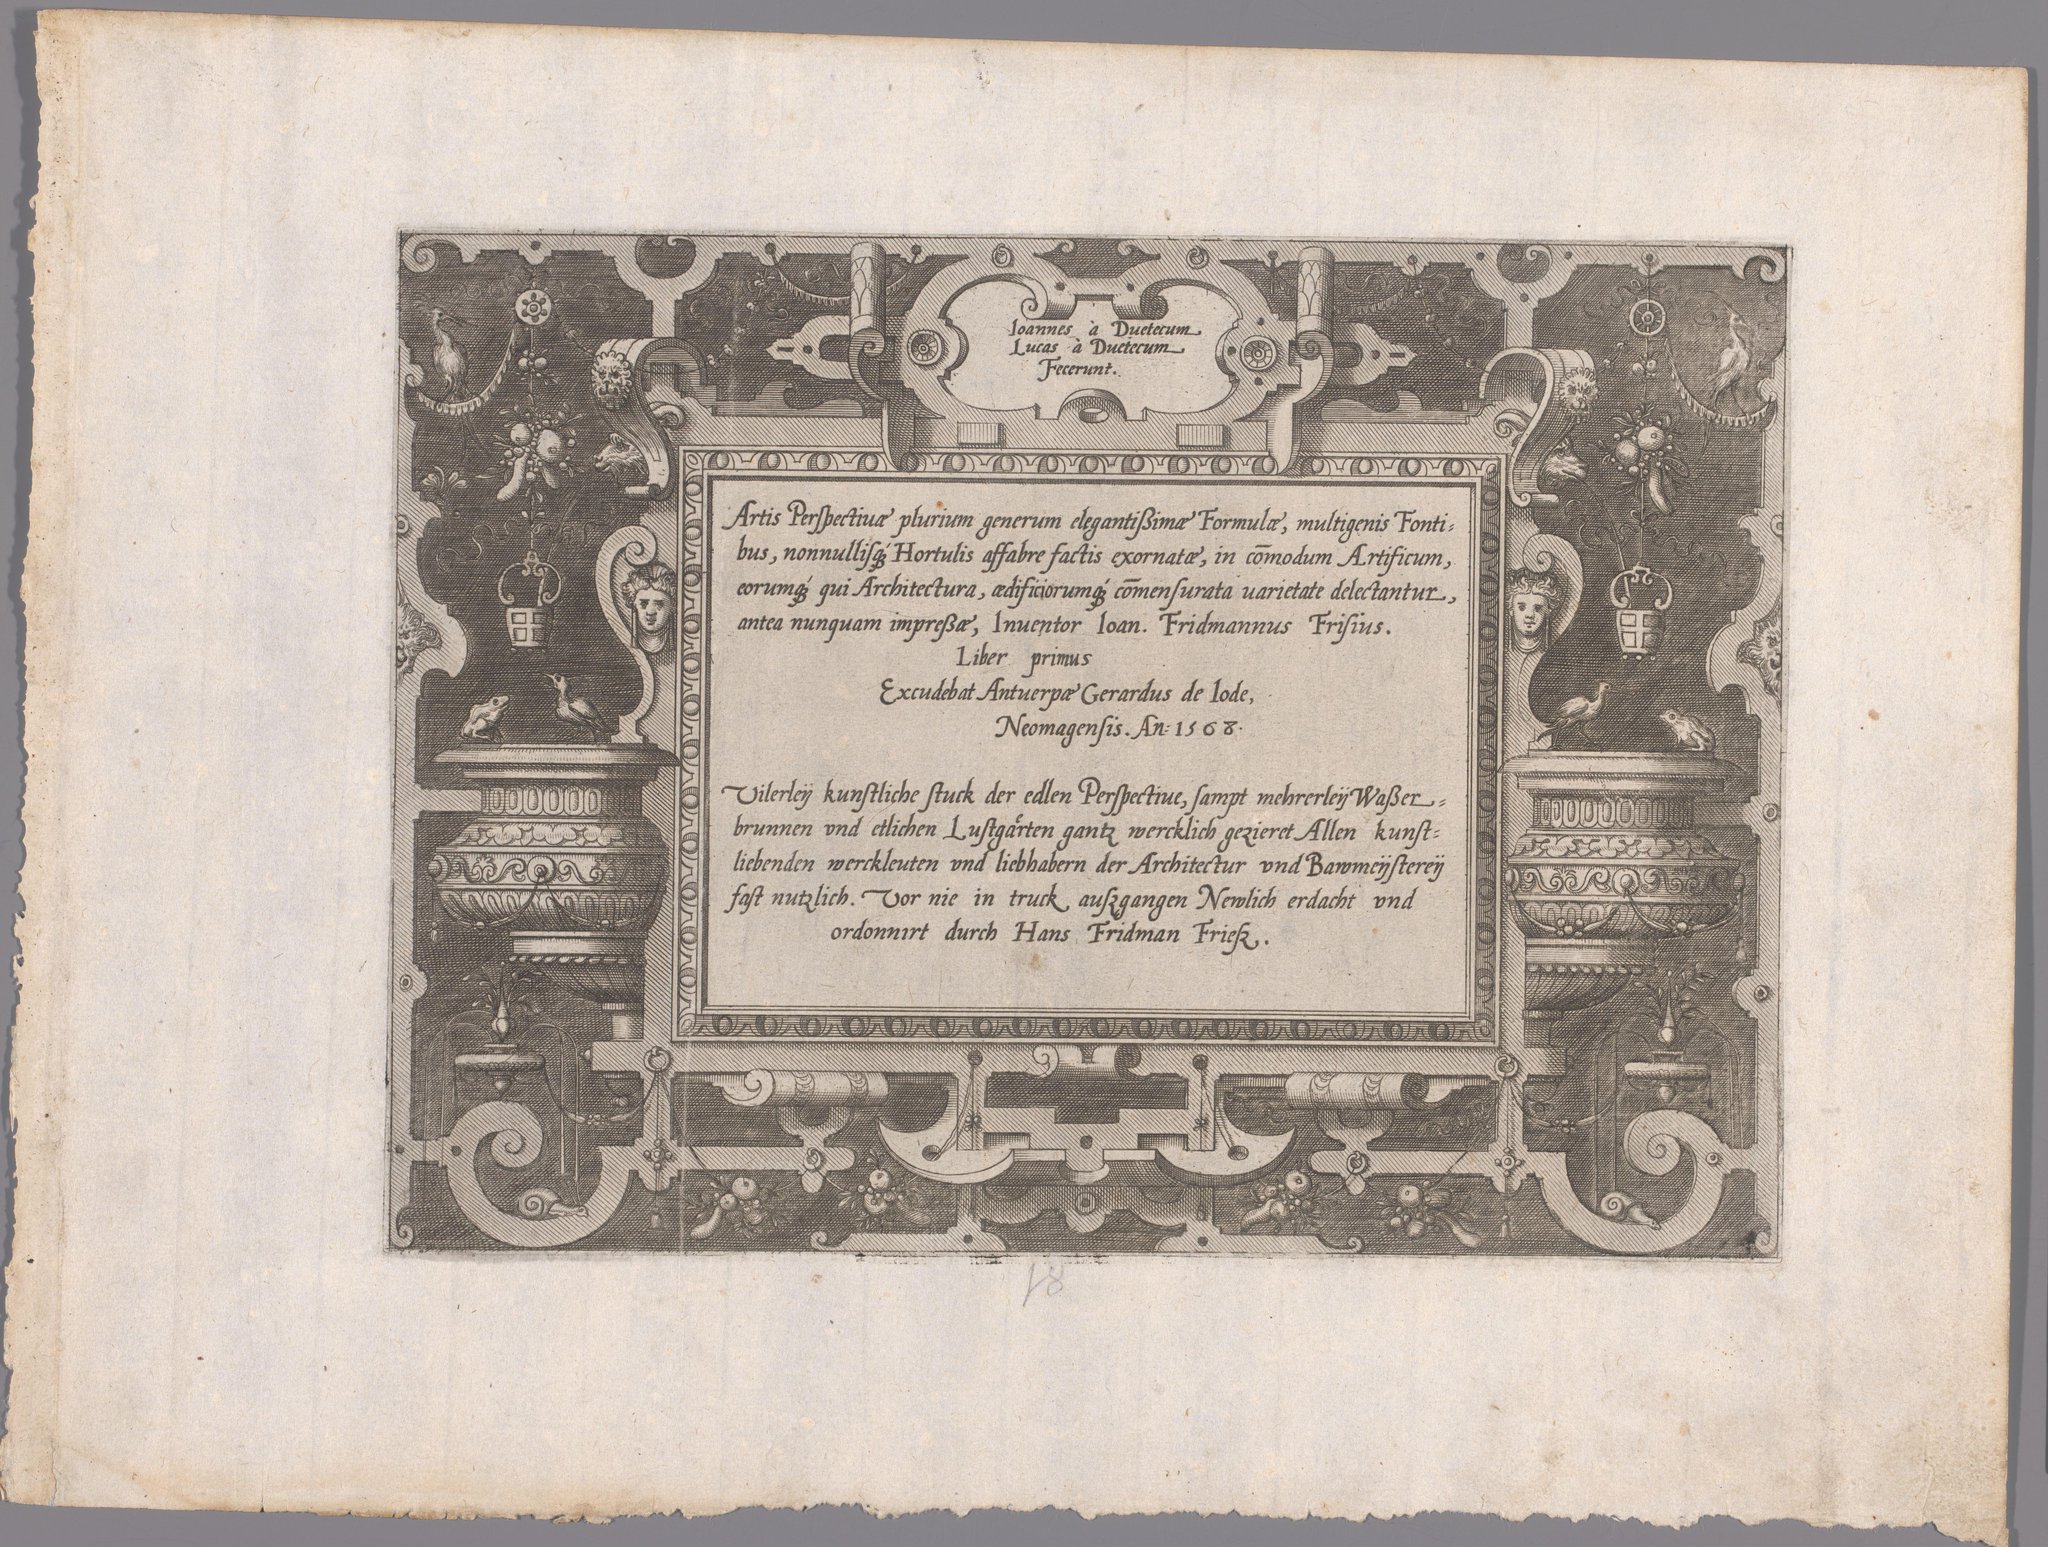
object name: ornament print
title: Artis Perspectivae (...)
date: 1568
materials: paper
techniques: etching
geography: antwerp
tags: scrollwork, strapwork ~ ornament, ornament ~ cartouche, ornamental fountain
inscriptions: date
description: De titel van de prentserie 'Artis Perspectivae' op een cartouche in een ornamentele lijst. Rechts en links een vat met een kikker en een vogel op de rand.